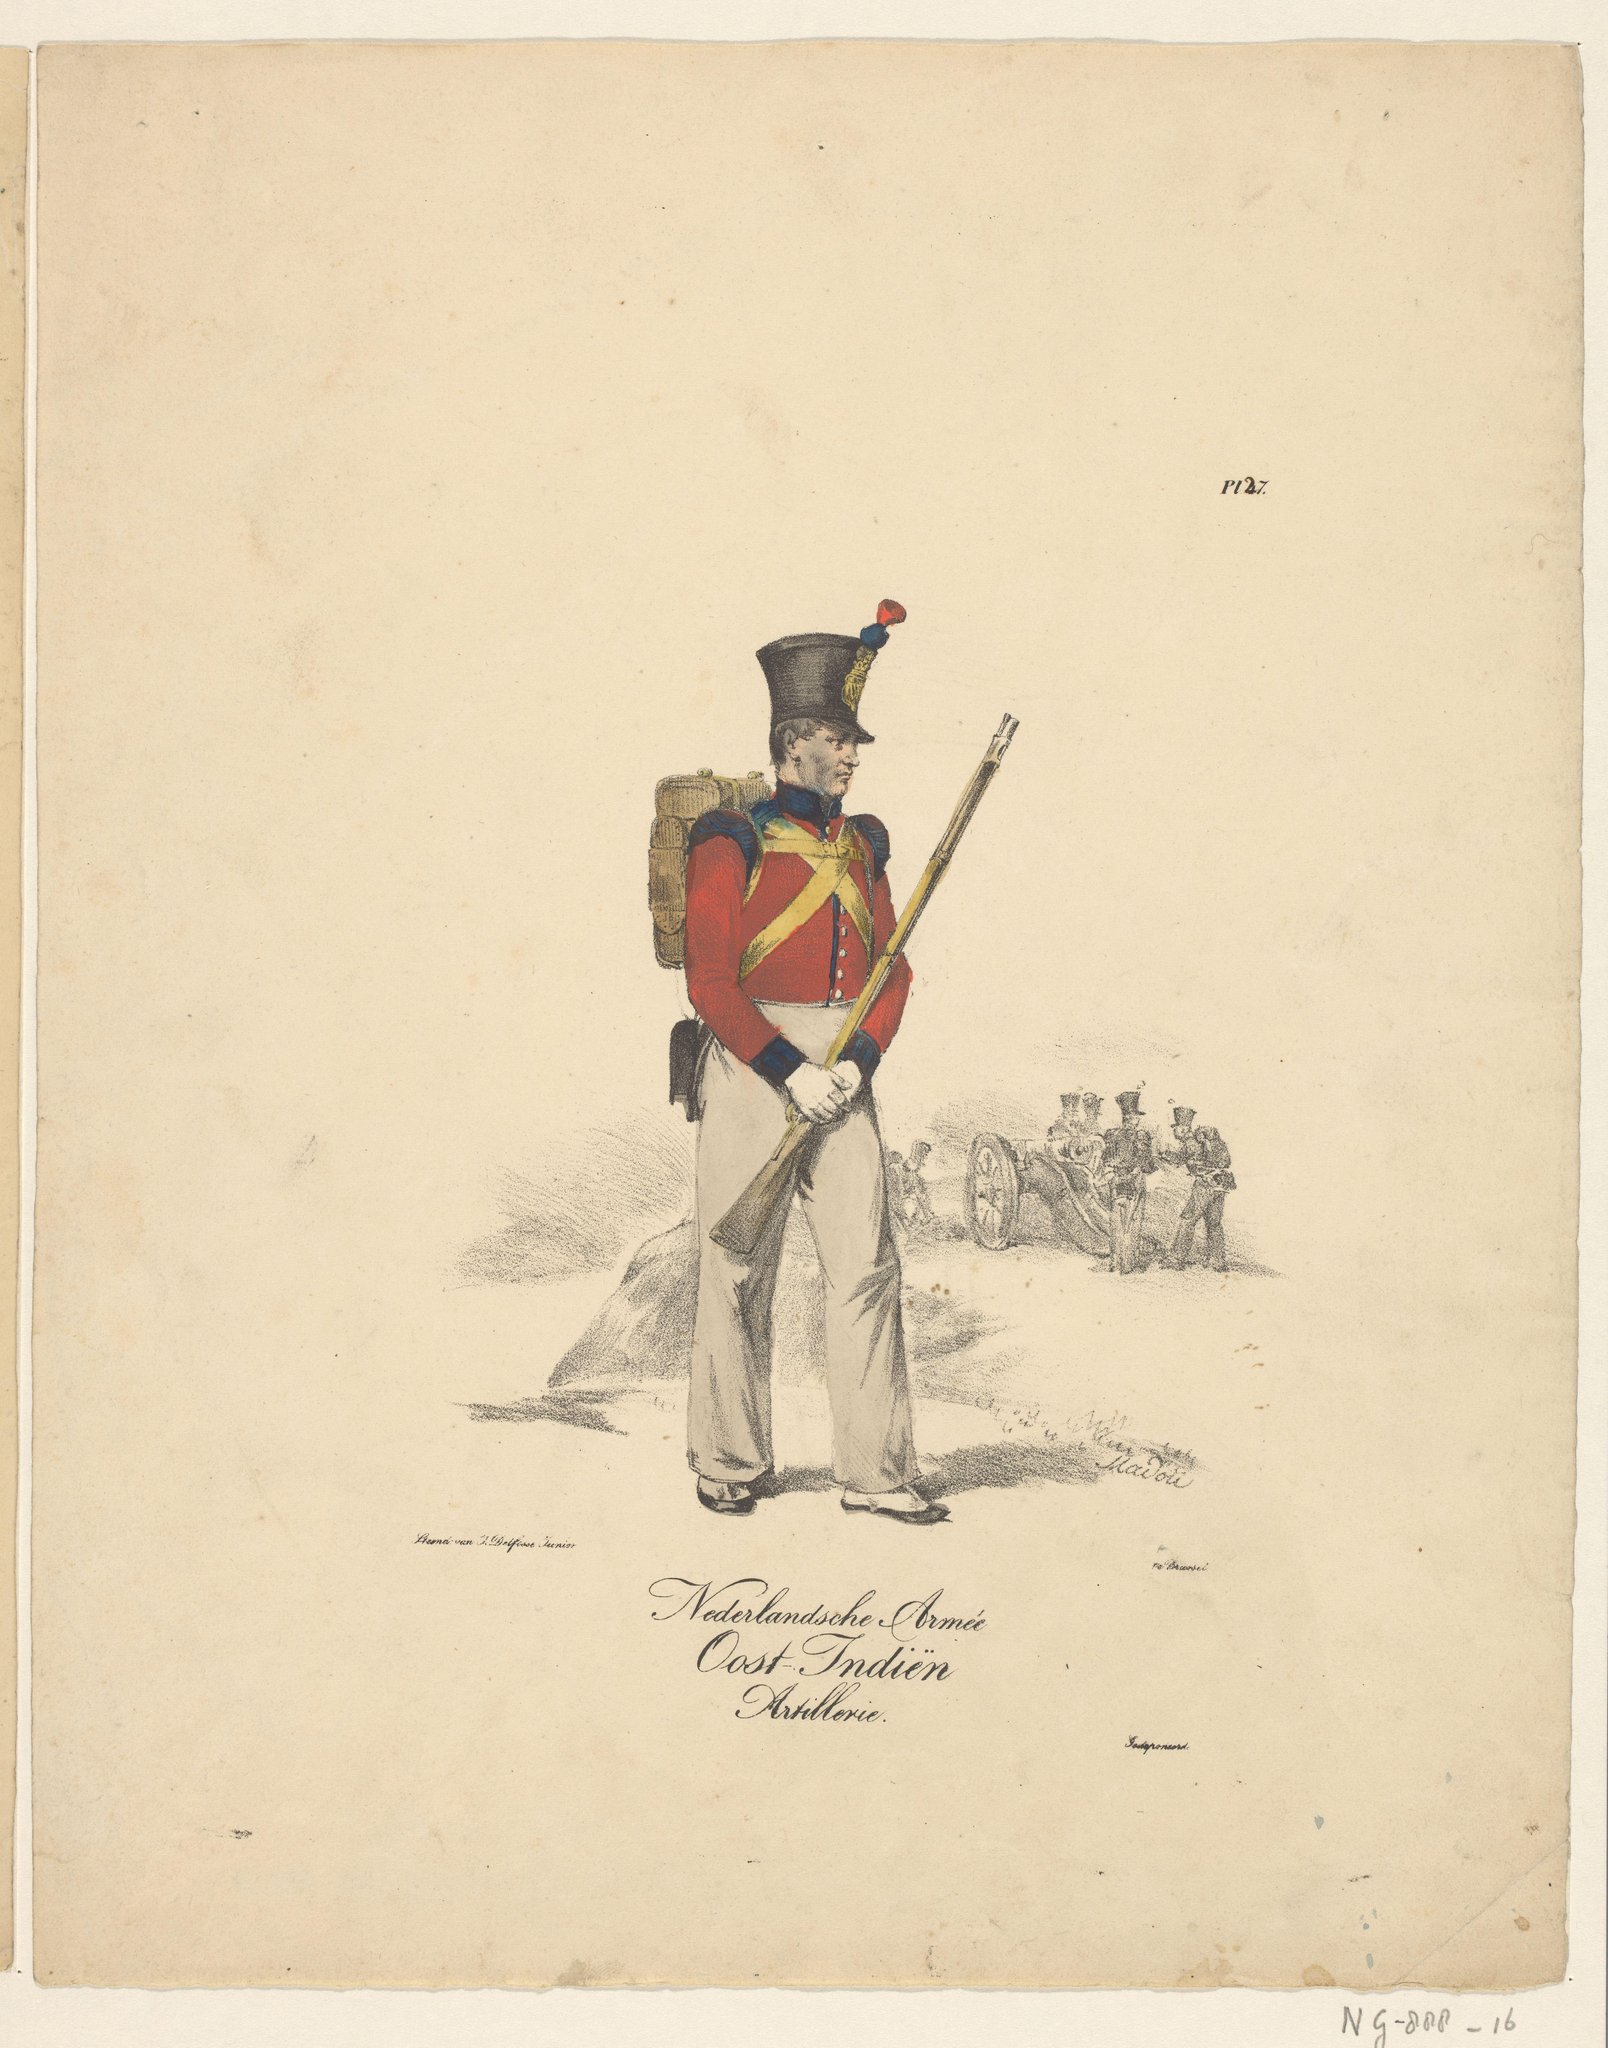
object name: costume print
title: Nederlandsche Armée / Oost-Indiën Artillerie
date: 1823-1827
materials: paper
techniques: hand coloring, lithograph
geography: brussels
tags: (military) uniforms (+ artillery), dutch east indies, the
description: Een soldaat van de artillerie van de Oost-Indische troepen. Op de achtergrond wordt een kanon geladen. Genummerd rechtsboven: 47. Afkomstig uit een plaatwerk van uniformen van het Nederlandse leger, ca. 1825.